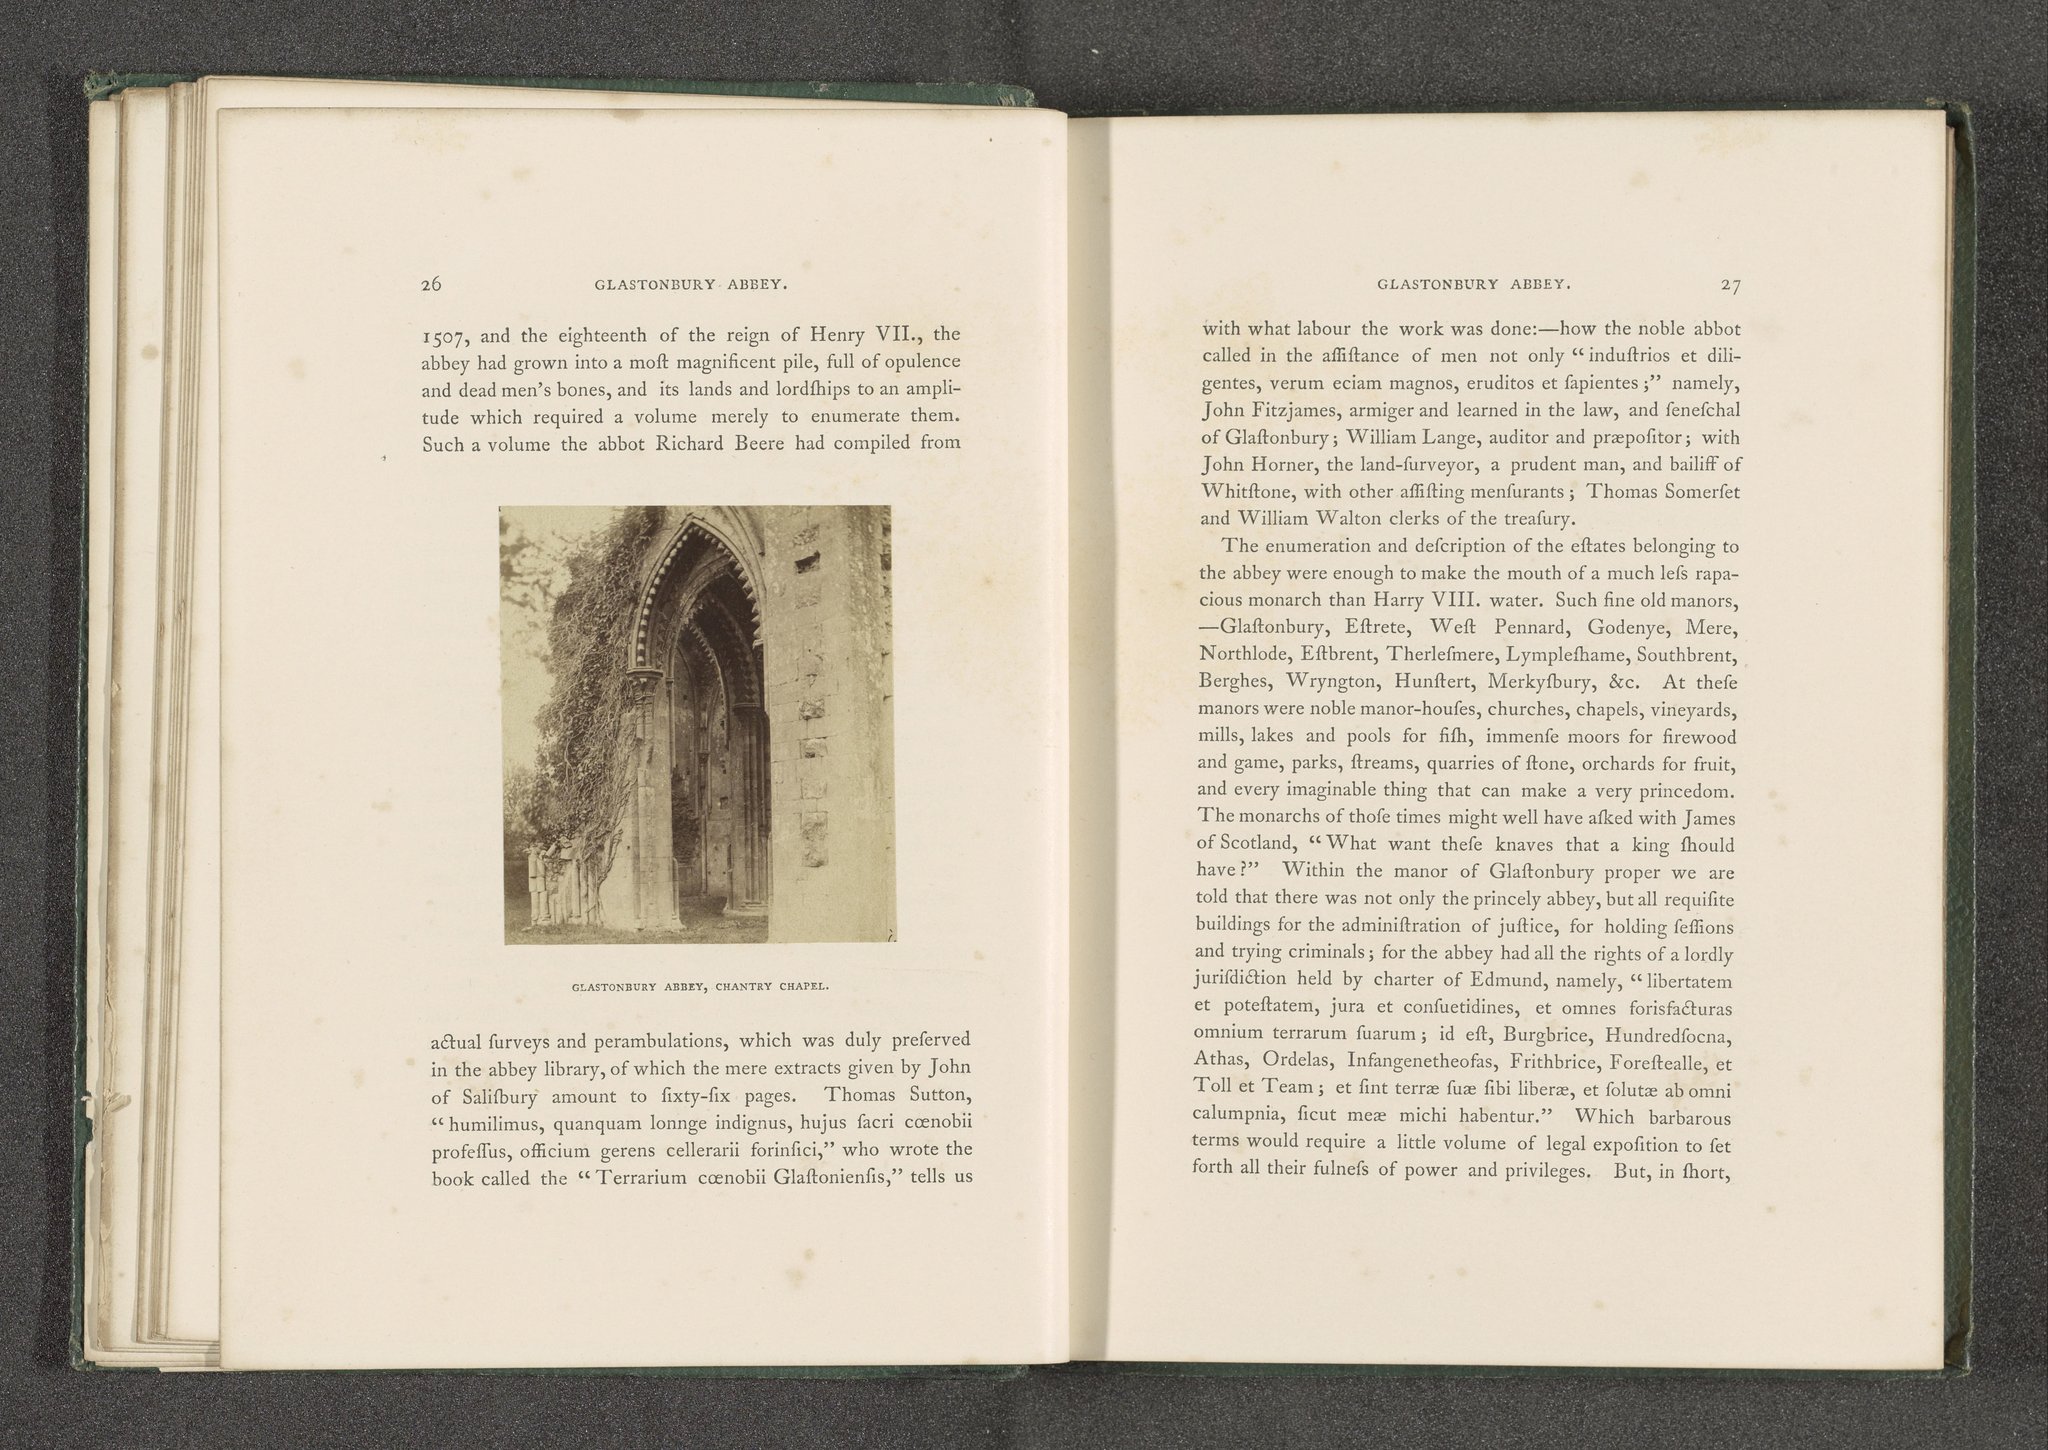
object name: page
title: Glastonbury Abbey, Chantry Chapel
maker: william russell sedgfield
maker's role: fotograaf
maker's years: 1826-1902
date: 1852-1862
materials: photographic support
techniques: albumen print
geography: glastonbury abbey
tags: ruin of church, monastery, etc.